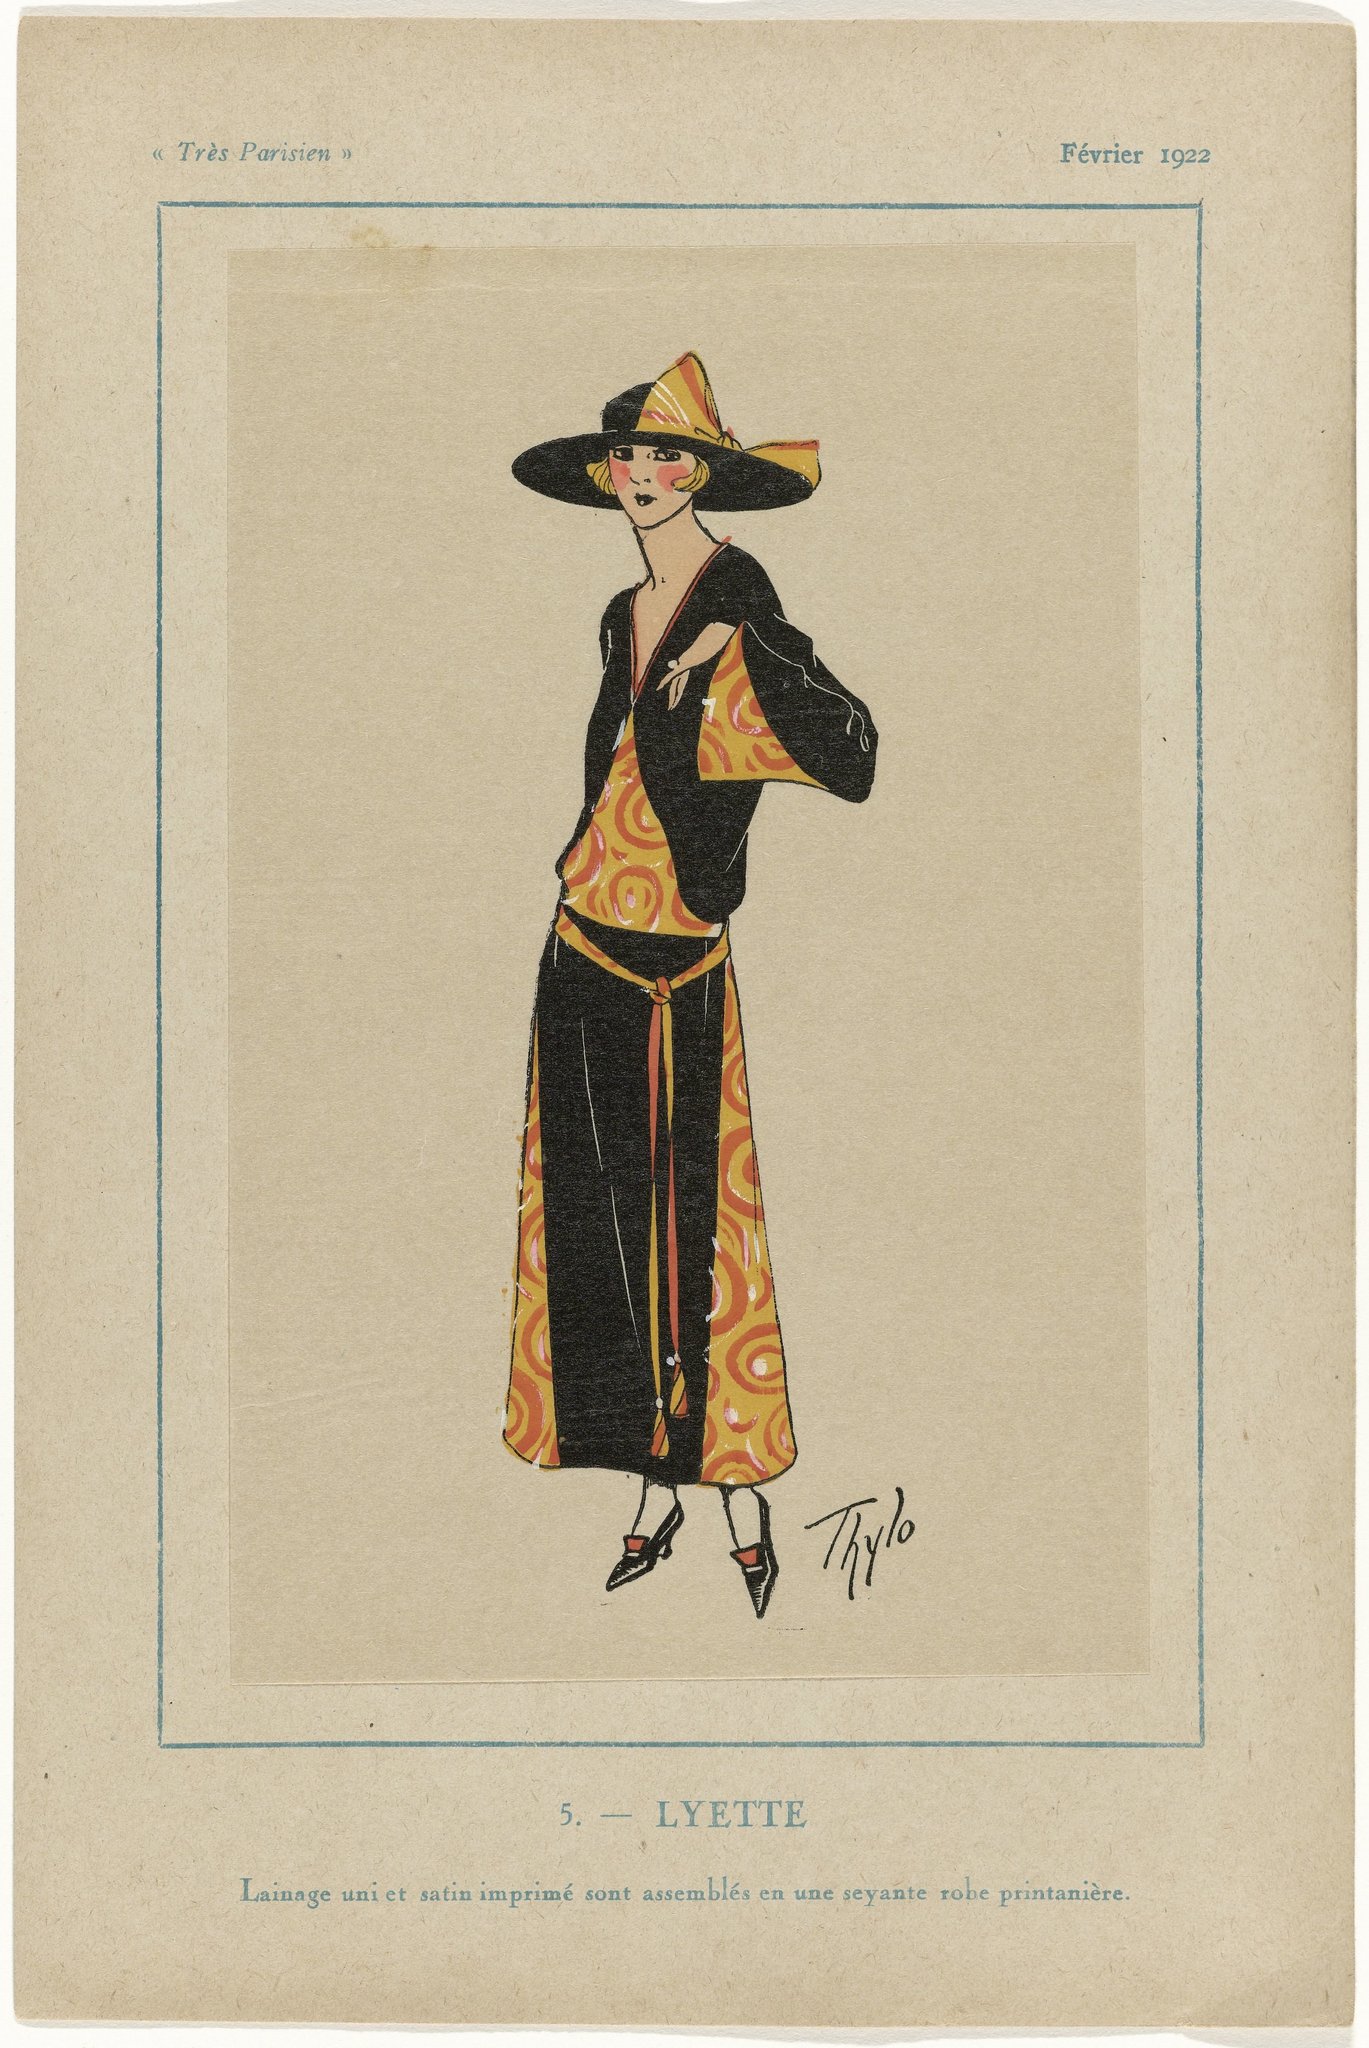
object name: fashion print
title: Très Parisien, février 1922: 5.- LYETTE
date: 1922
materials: paper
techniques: hand coloring, letterpress printing, lithography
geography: paris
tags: fashion plates, head-gear: hat (+ women's clothes), dress, gown (+ women's clothes), belt, girdle, waistband (+ women's clothes)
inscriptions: caption: ‘5. - LYETTE / Lainage uni et satin imprimé sont assemblés en une seyante robe printanière.’, title: ‘Très Parisien / Février 1922’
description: Japon van wol en bedrukt satijn, met ceintuur. Hoed met brede rand in dezelfde stof. Prent uit het modetijdschrift Très Parisien (1920-1936).